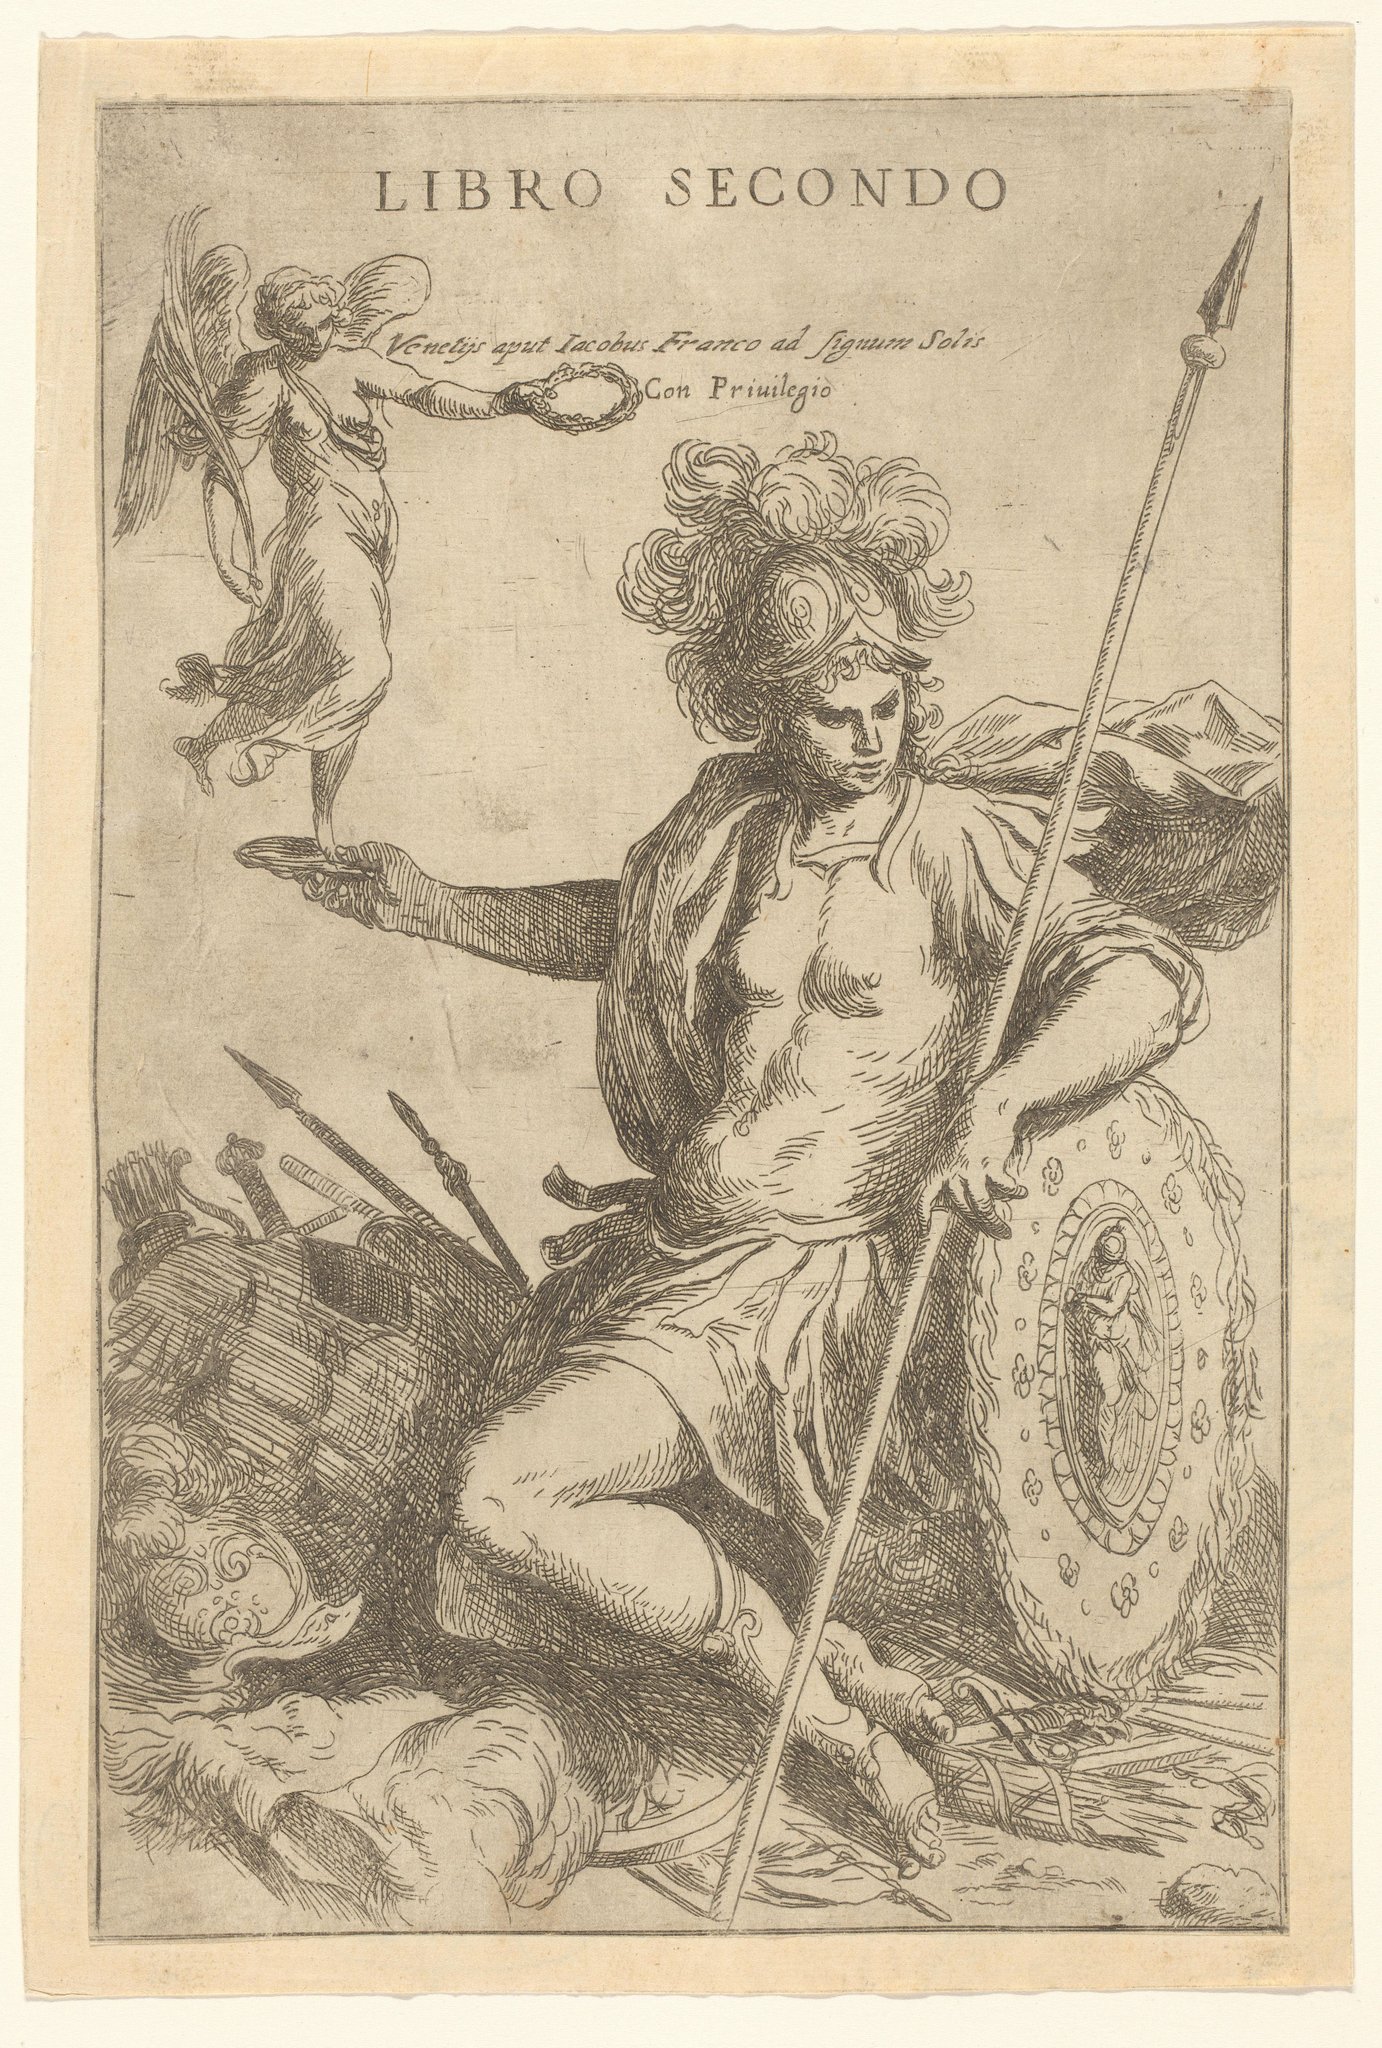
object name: titelprent, frontispice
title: Titelblad met Minerva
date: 1554-1611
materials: paper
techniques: etching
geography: venice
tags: minerva as patroness, fame; 'fama', 'fama buona', 'fama chiara' (ripa)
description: Titelprent van Giacomo Franco's "De Excellentia et Nobilitate Delineationis Libri Duo", 1611. Dit is de tweede staat, de eerste staat is gebruitk als titelprent van Giacomo Franco's boek "Camei, Triumphi, Ornamenta, Animalia", een verzameling prenten naar tekeningen van Giacomo Palma de Oude. K.Botke